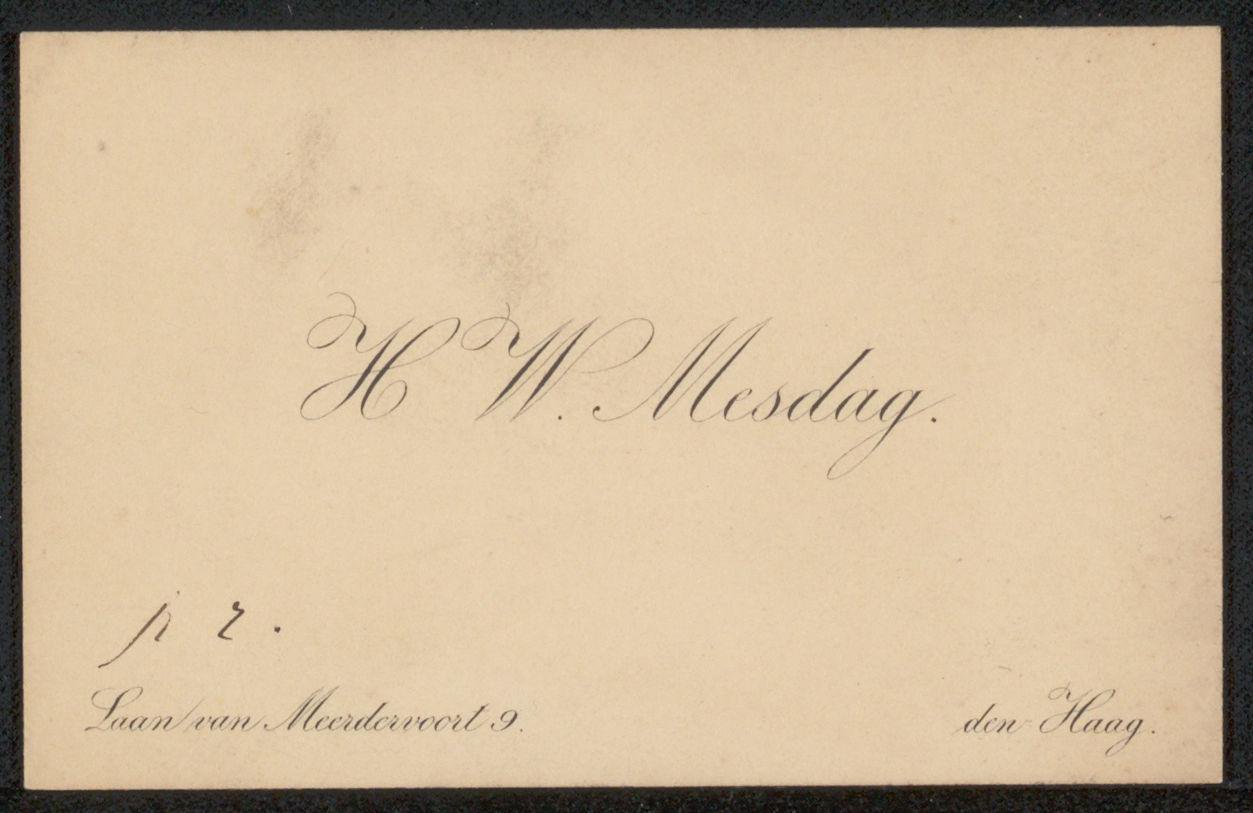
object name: visiting card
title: Visitekaartje aan Philip Zilcken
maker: hendrik willem mesdag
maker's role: draughtsman, painter, print maker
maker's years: 1831-1915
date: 1841-1915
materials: cardboard, ink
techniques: pen, printing, writing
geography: the hague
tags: the hague, painter, draughtsman, philip zilcken